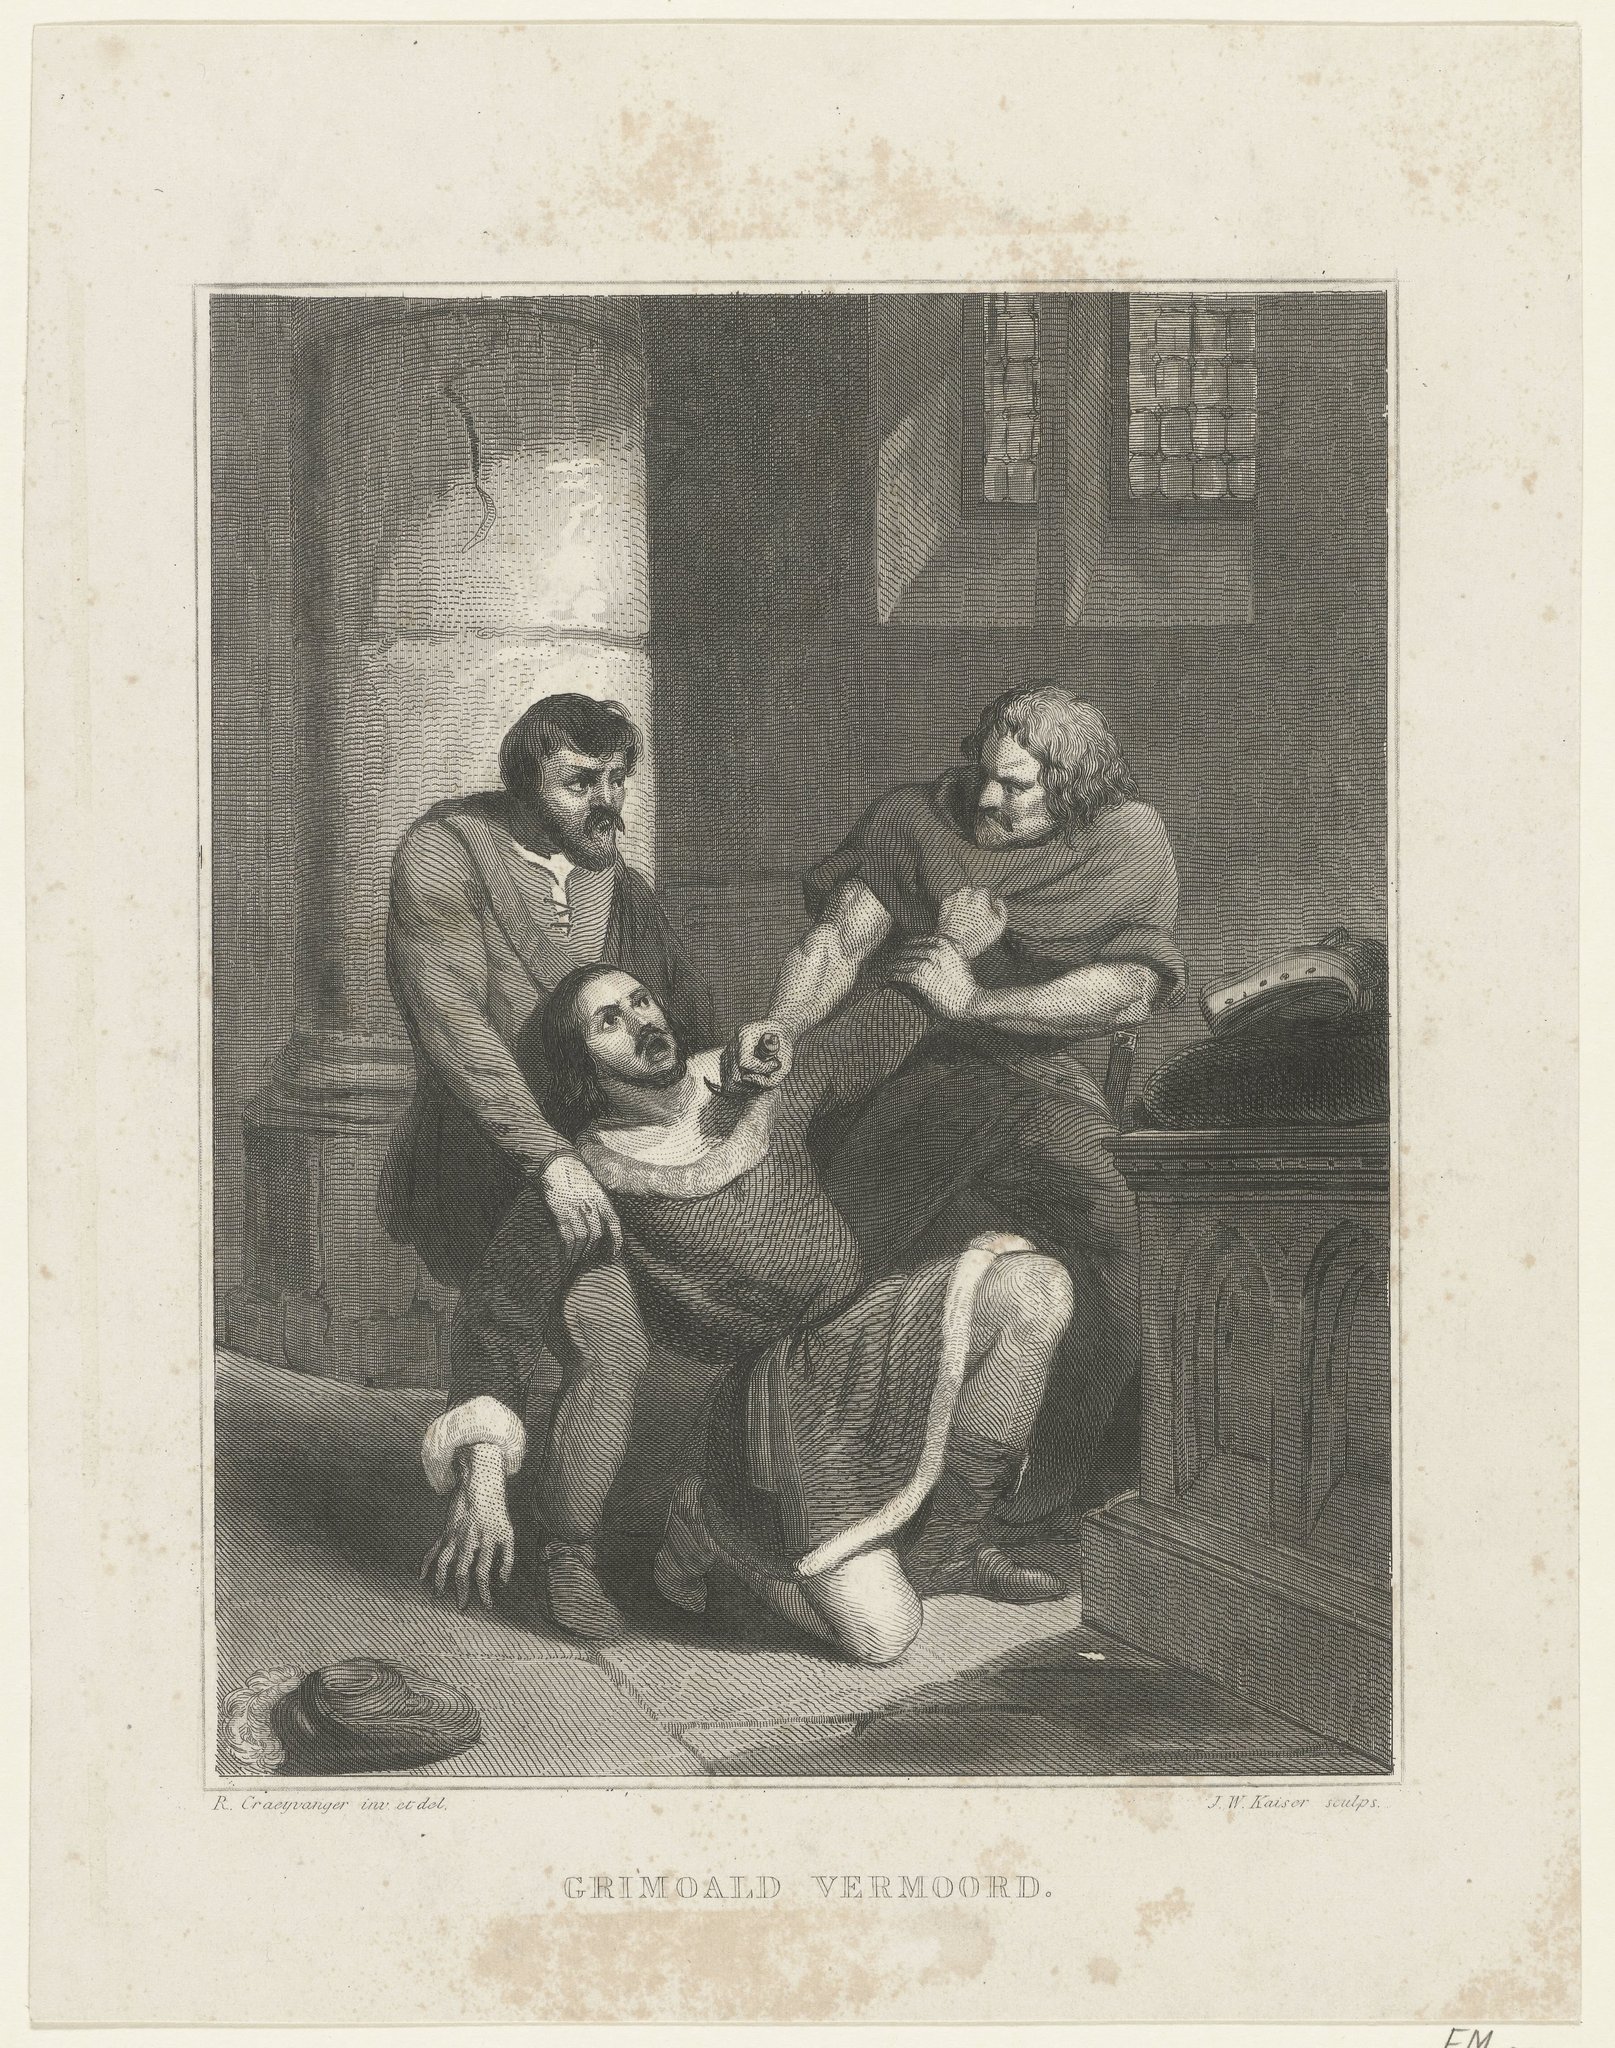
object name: print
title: Grimoald vermoord, 714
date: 1838-1840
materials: paper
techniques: engraving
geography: netherlands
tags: liège, attempt, political murder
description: Grimoald, hertog van Neustrië, zoon van Pippijn II van Herstal, wordt in 714 vermoord door een heidense Fries op de tombe van St. Lambert in de Sint-Lambertuskathedraal te Luik.